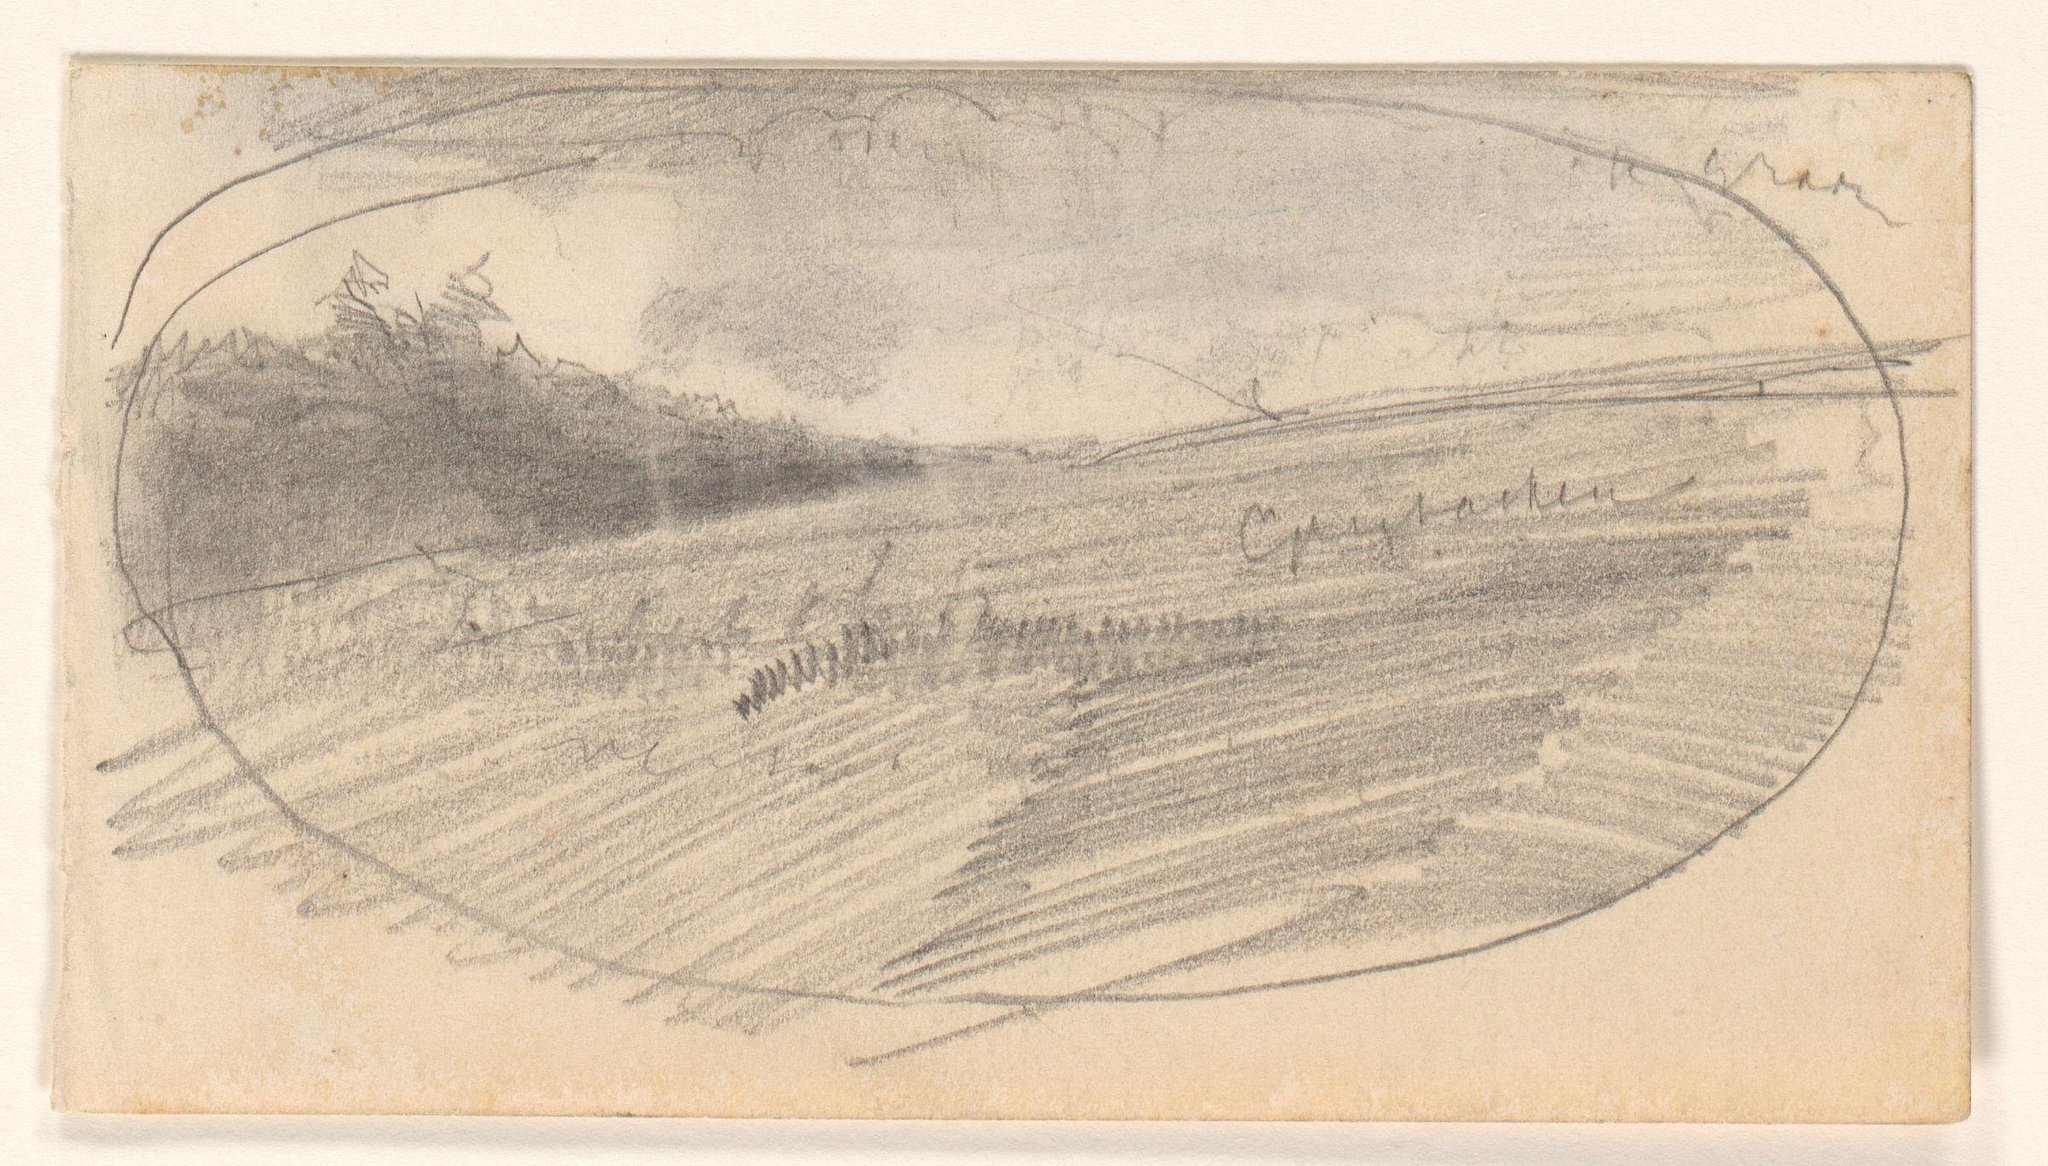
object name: drawing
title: Landschapschets in een ovaal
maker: august allebé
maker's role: draughtsman, print maker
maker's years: 1838-1927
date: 1848-1927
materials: paper, pencil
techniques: brush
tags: meadow, pasture